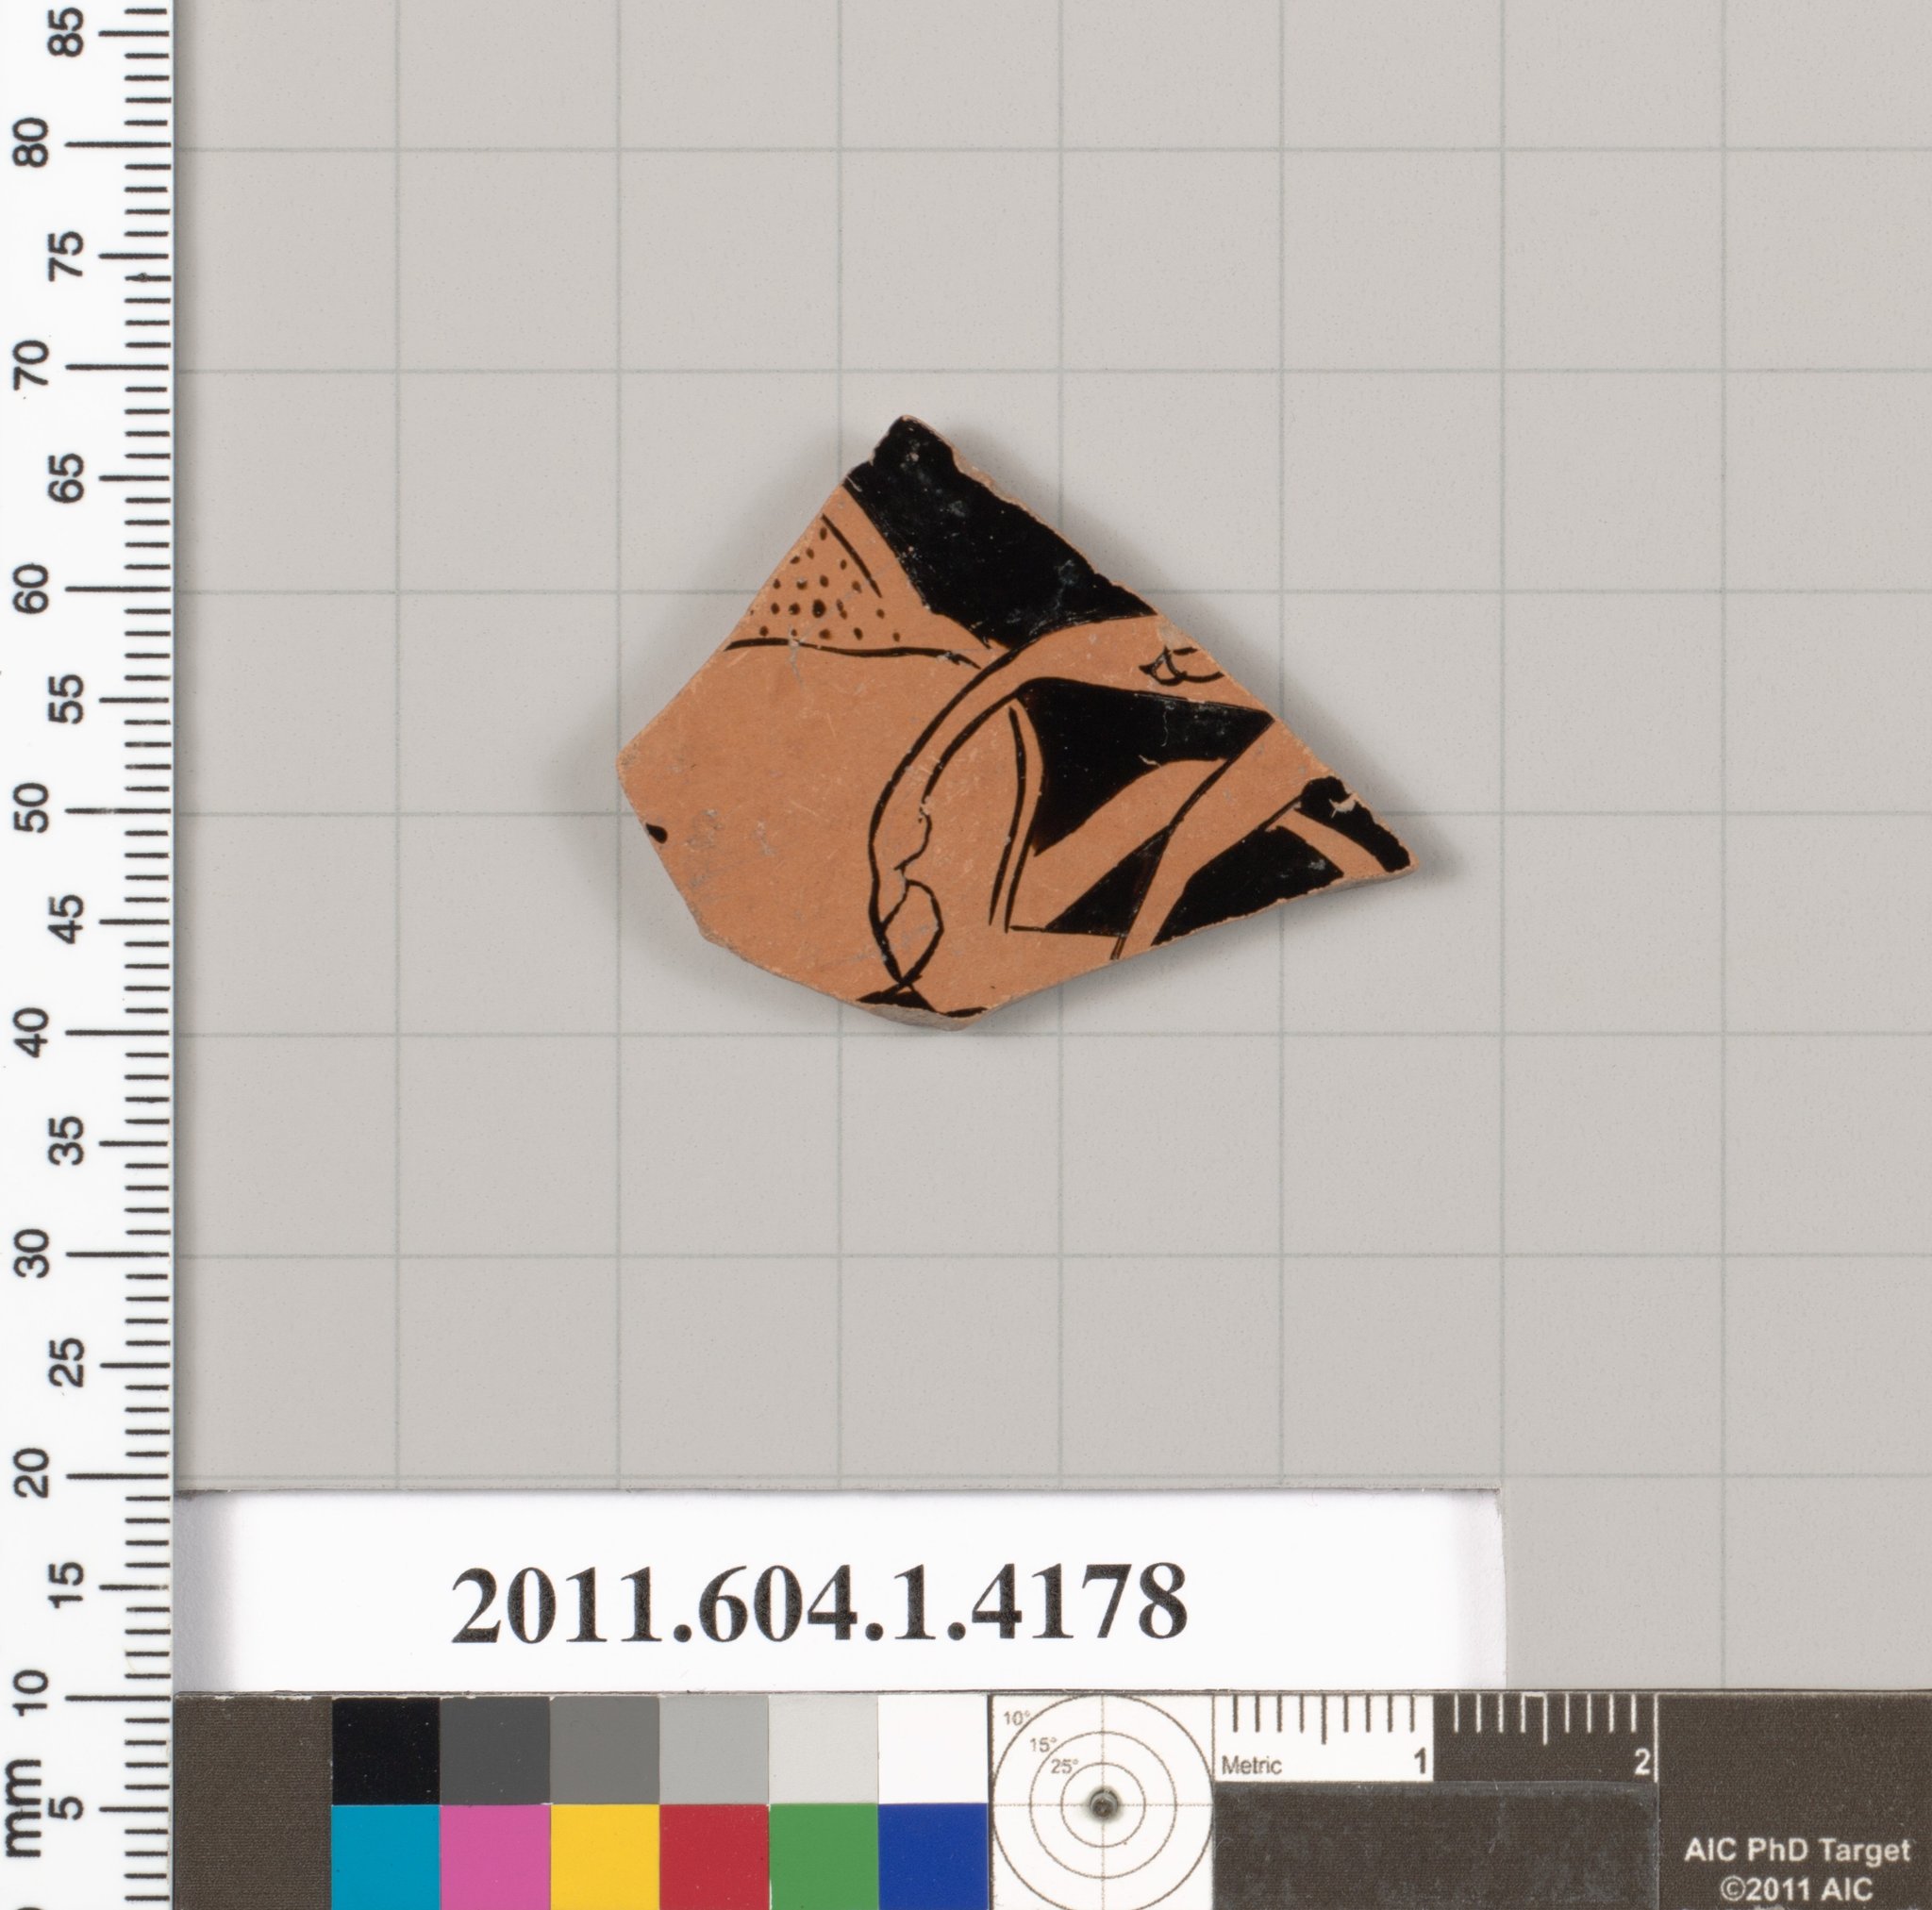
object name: kylix fragment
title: Terracotta fragment of a kylix (drinking cup)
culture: greek, attic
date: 500-480 BCE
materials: terracotta